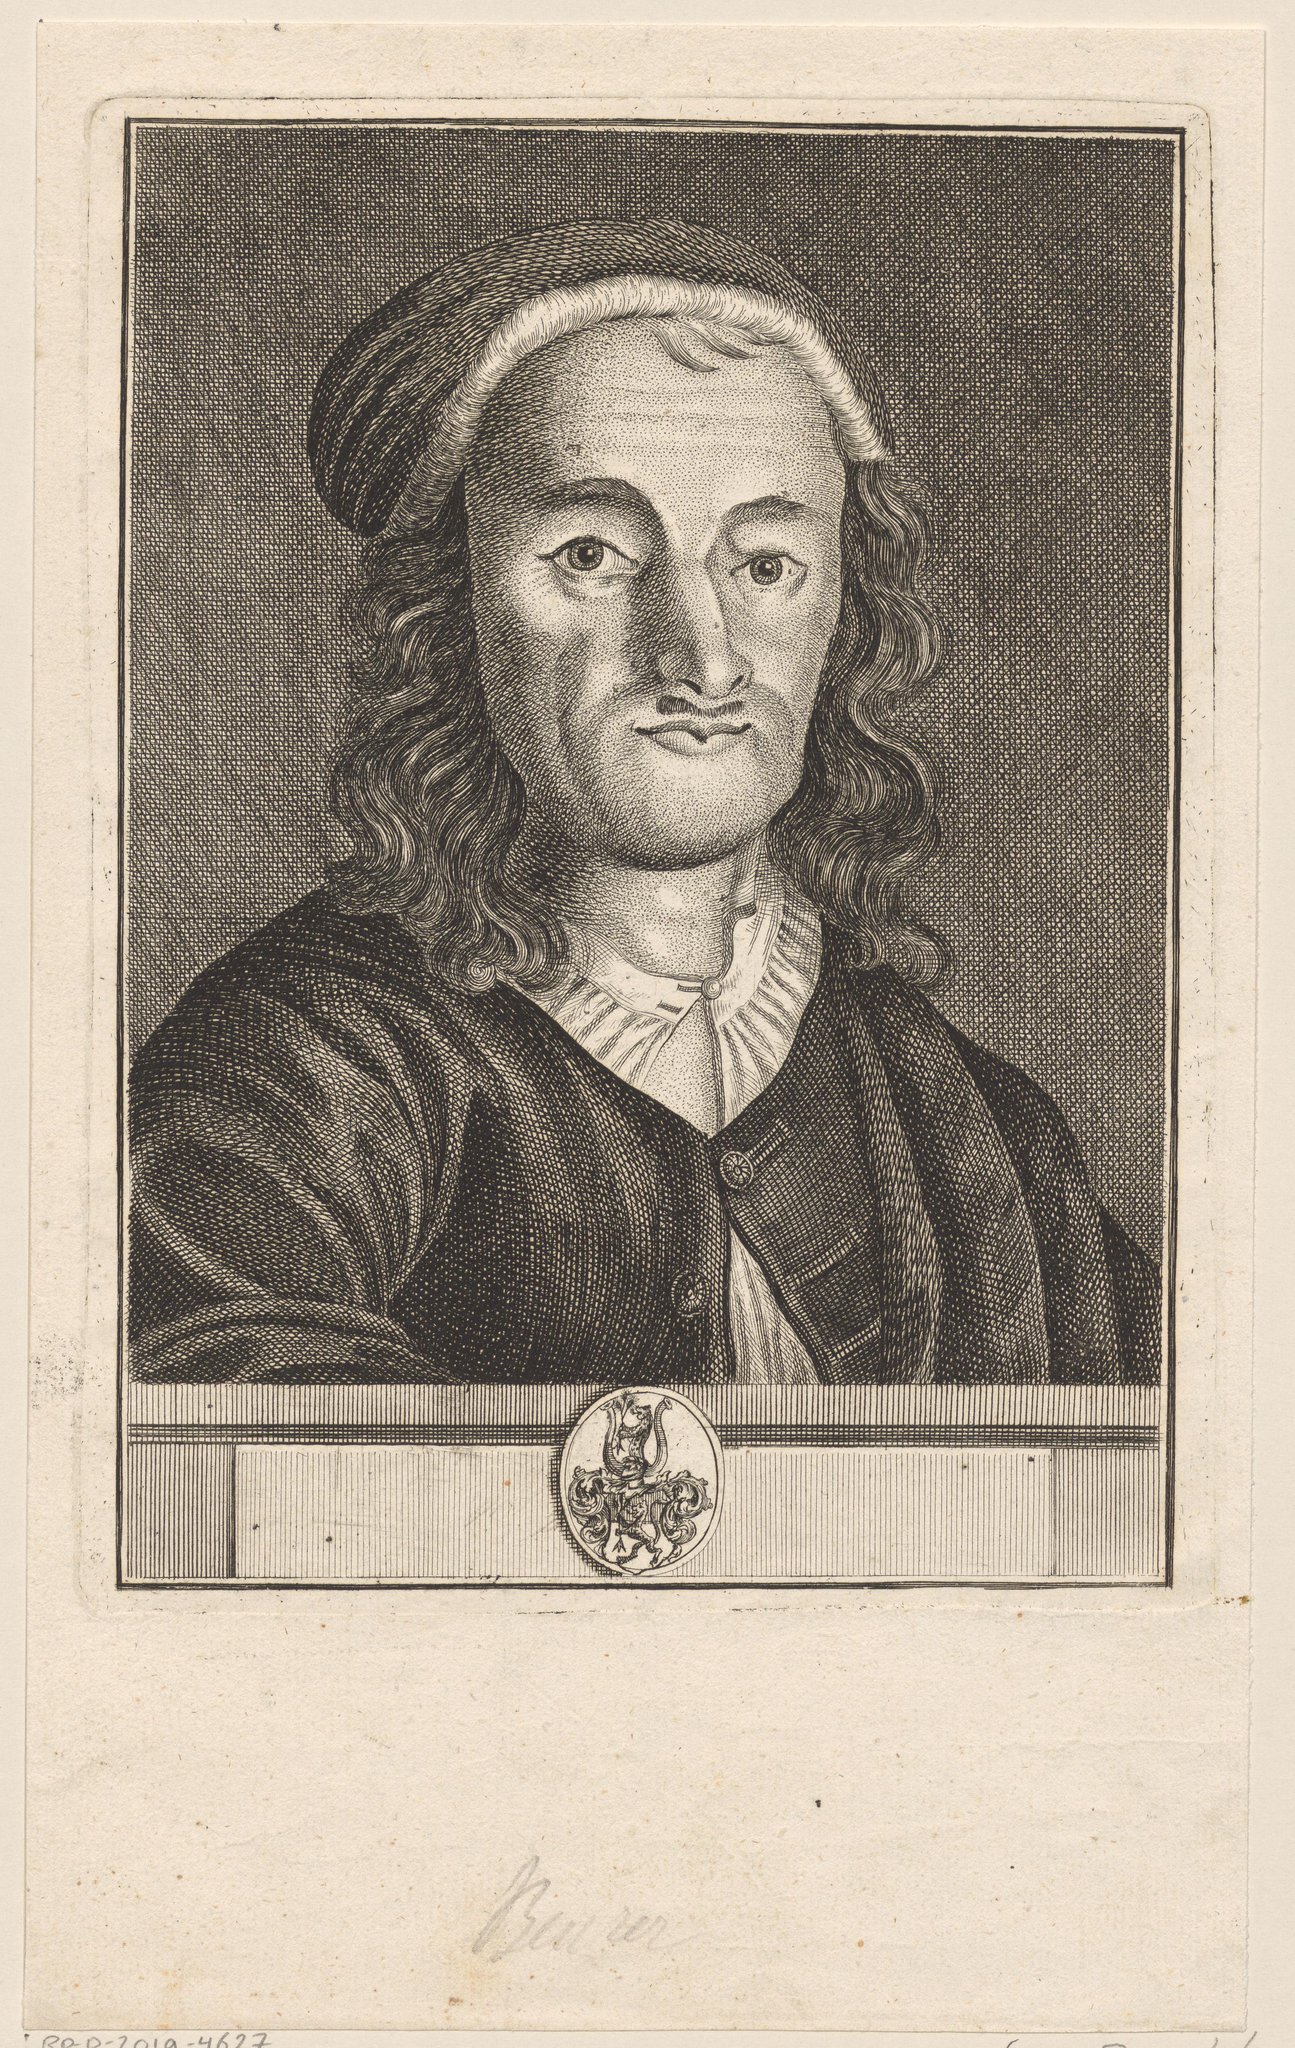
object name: print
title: Portret van Abraham Beurer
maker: johann christoph dehne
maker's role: print maker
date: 1714-1726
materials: paper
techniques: engraving, etching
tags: historical persons, portrait, self-portrait of painter, armorial bearing, heraldry